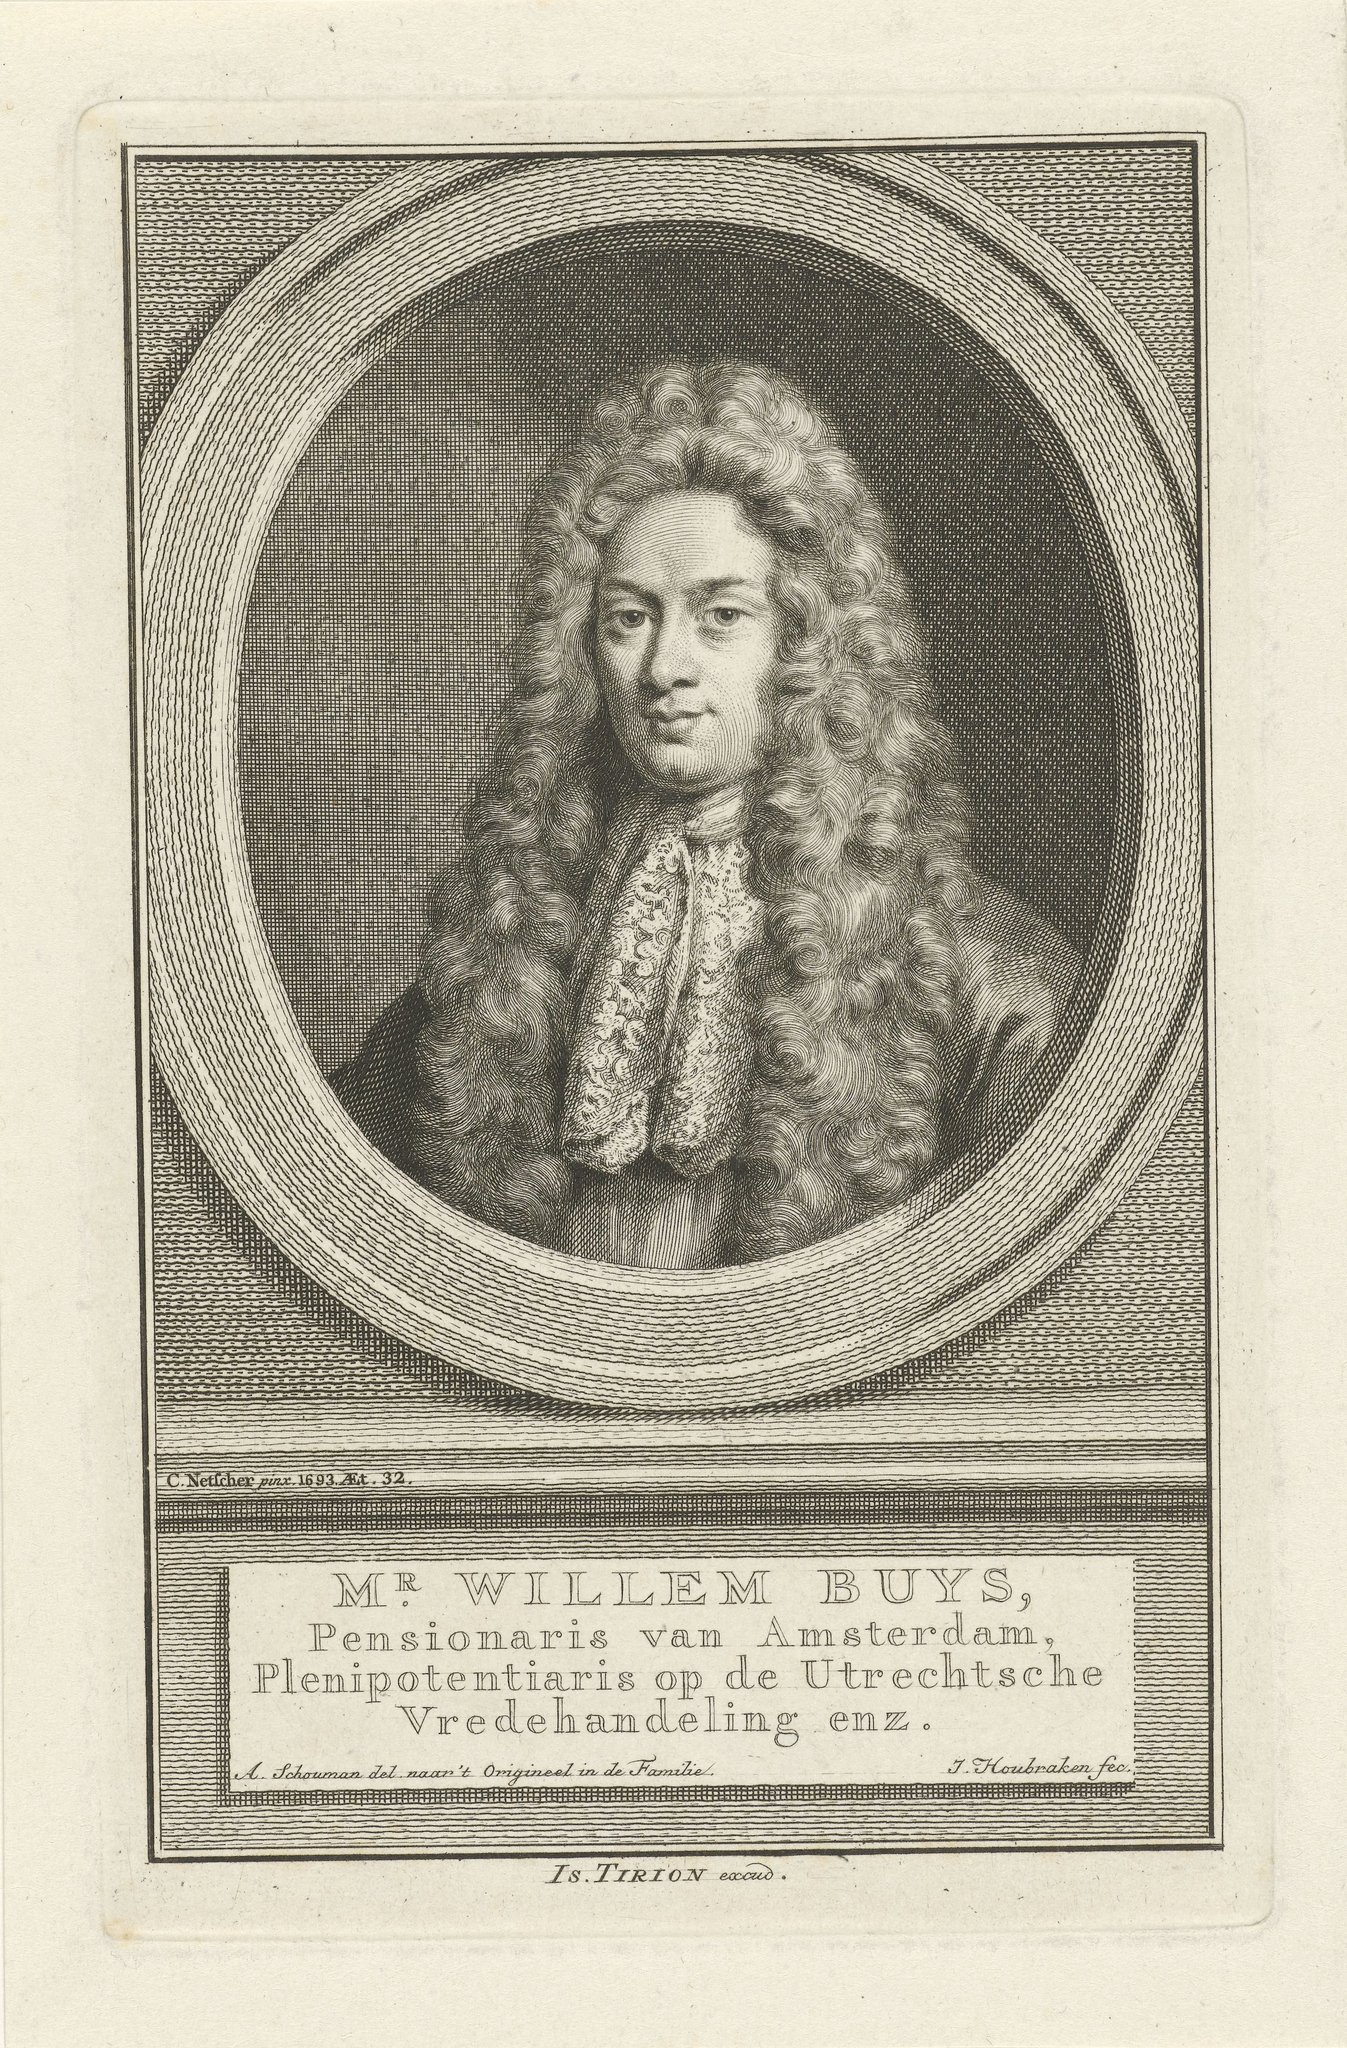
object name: print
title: Portret van Willem Buys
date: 1749-1759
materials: paper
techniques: engraving, etching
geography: amsterdam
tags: willem buys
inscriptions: collector's mark: Lugt 2228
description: Prent ook gebruikt in: Jan Wagenaar, Vaderlandsche historie, vervattende de geschiedenissen der nu Vereenigde Nederlanden, inzonderheid die van Holland (...), 21 delen. Amsterdam, Isaak Tirion, 1749-59.